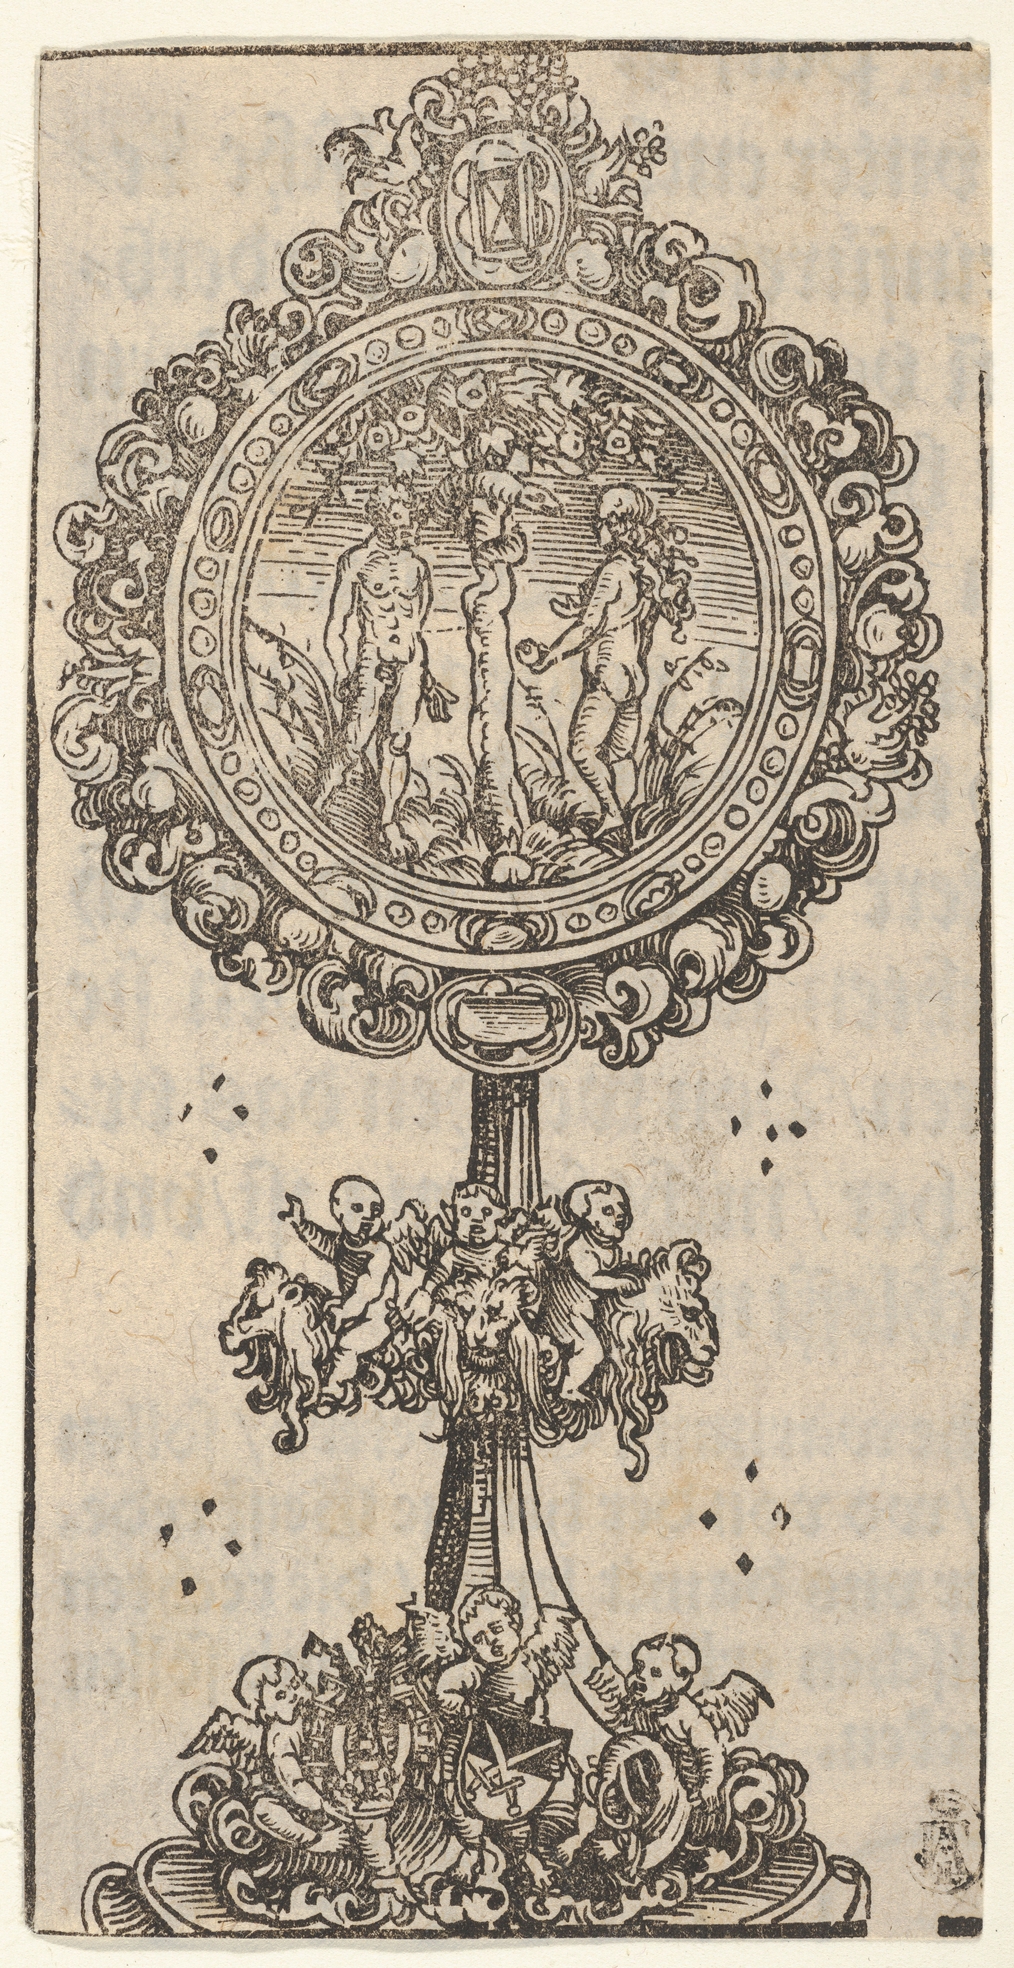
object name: print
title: A Relief with Adam and Eve, from the "Wittenberg Reliquaries"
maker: lucas cranach the elder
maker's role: artist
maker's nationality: german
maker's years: 1472-1553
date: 1509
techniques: woodcut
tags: lions,angels,adam,eve,reliquaries